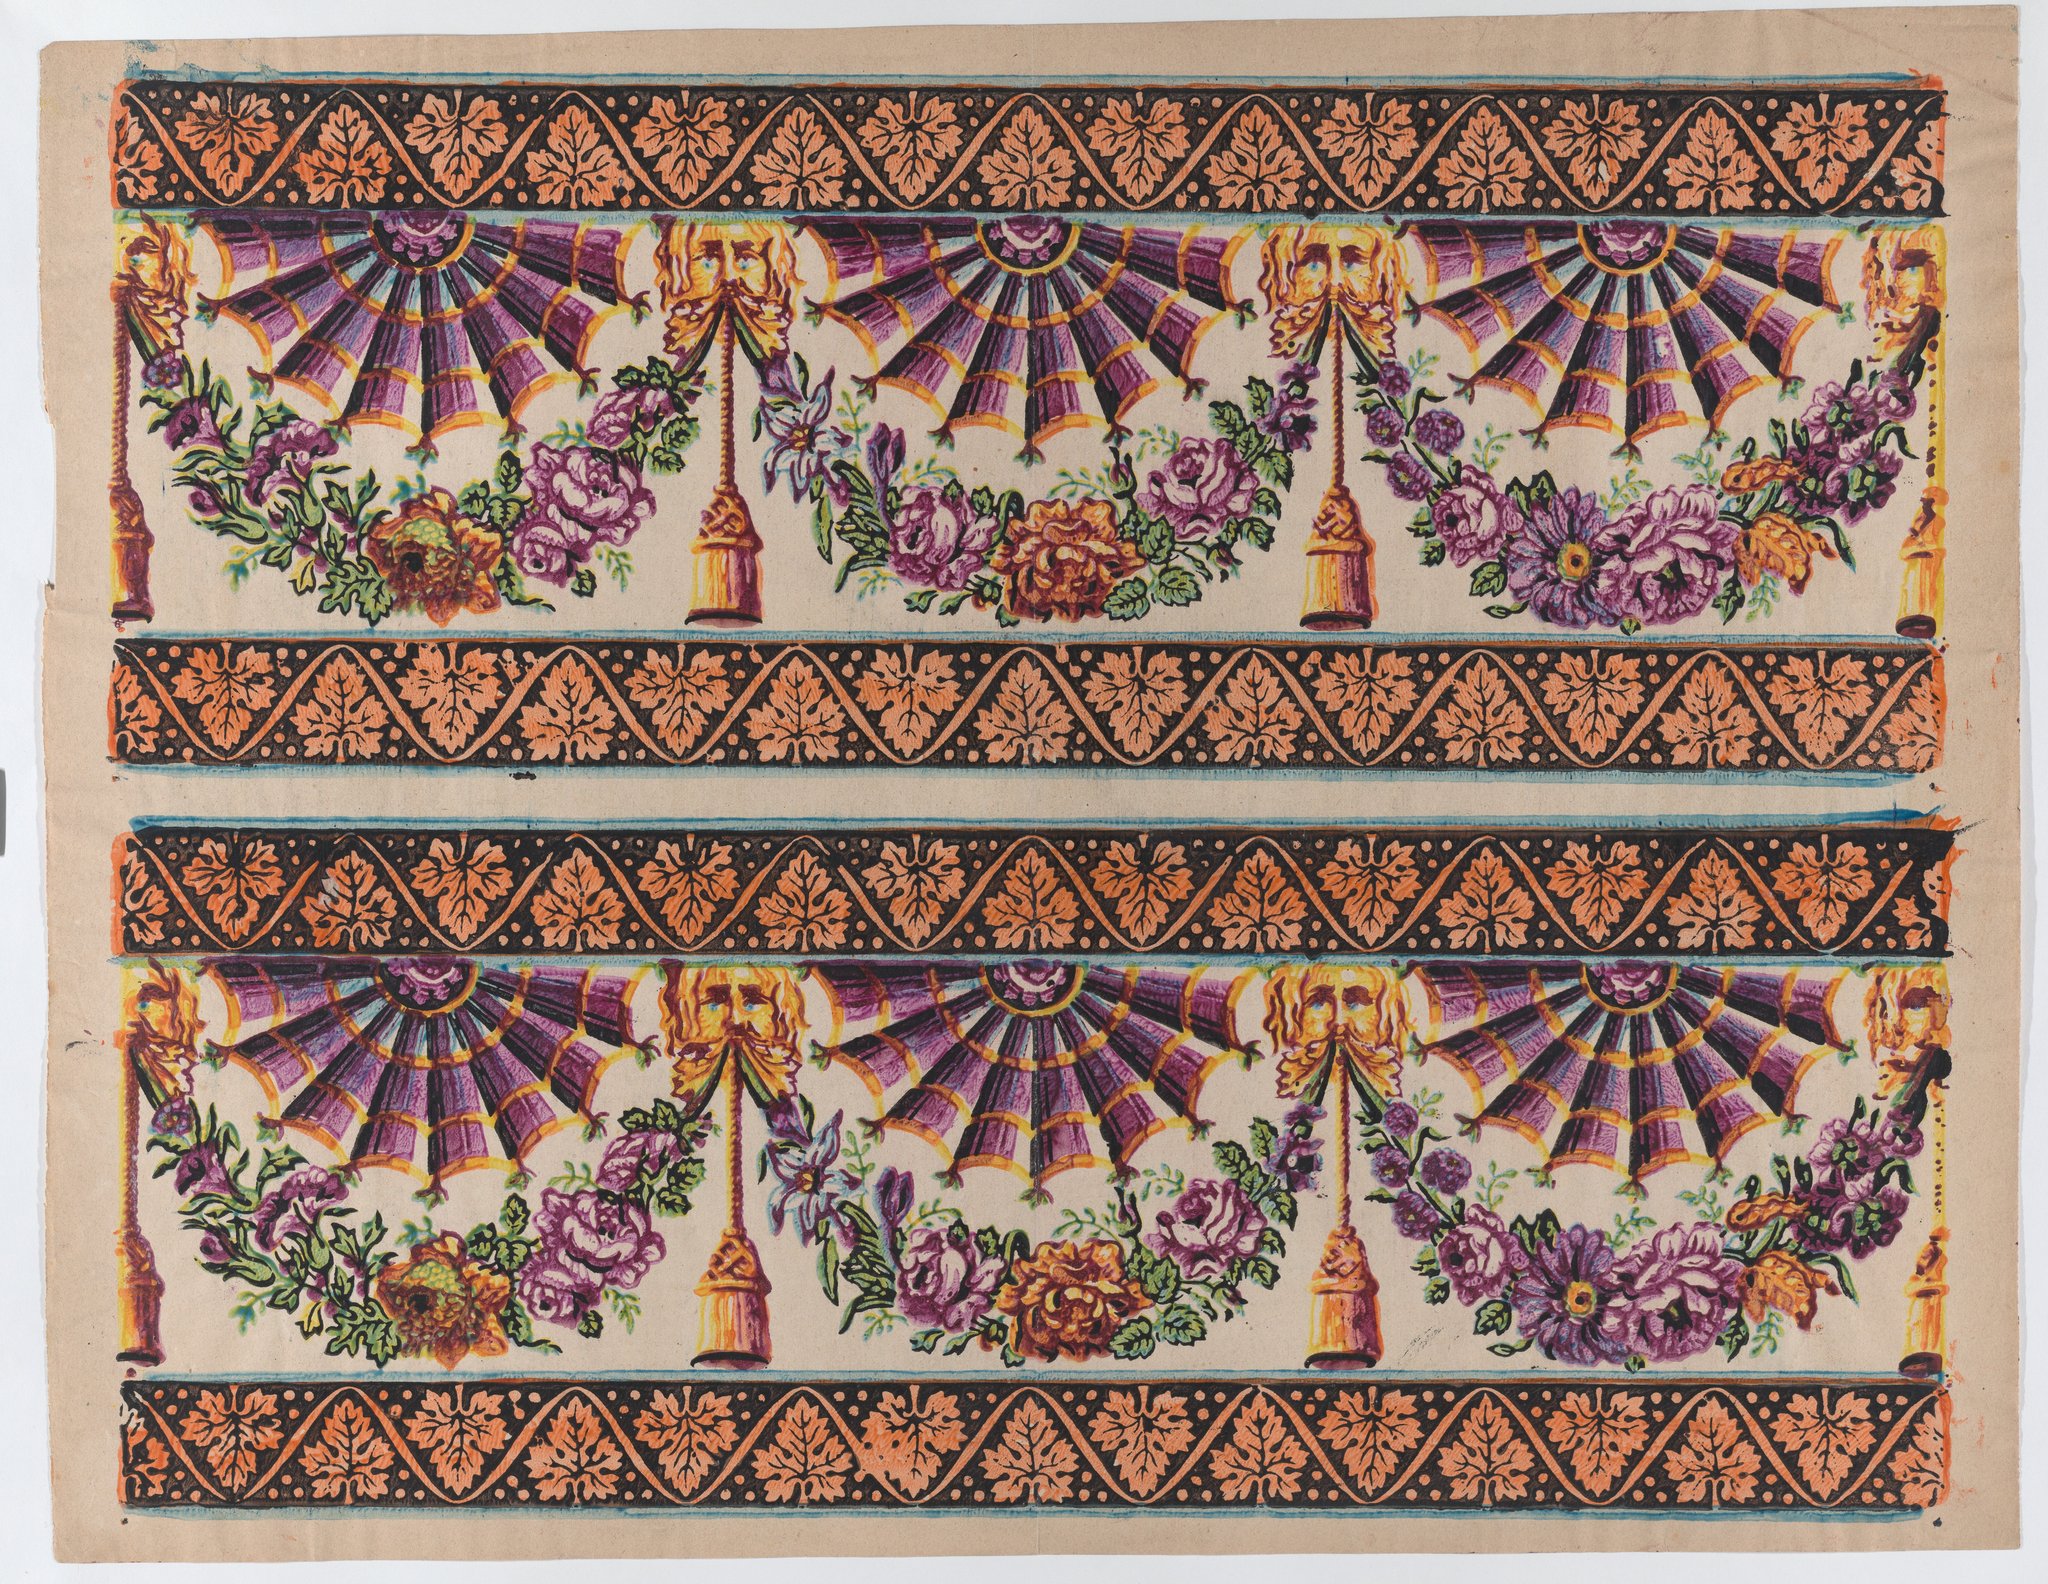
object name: print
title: Sheet with two borders with three fans and floral garlands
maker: Anonymous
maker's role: artist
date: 1767-1866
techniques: relief print